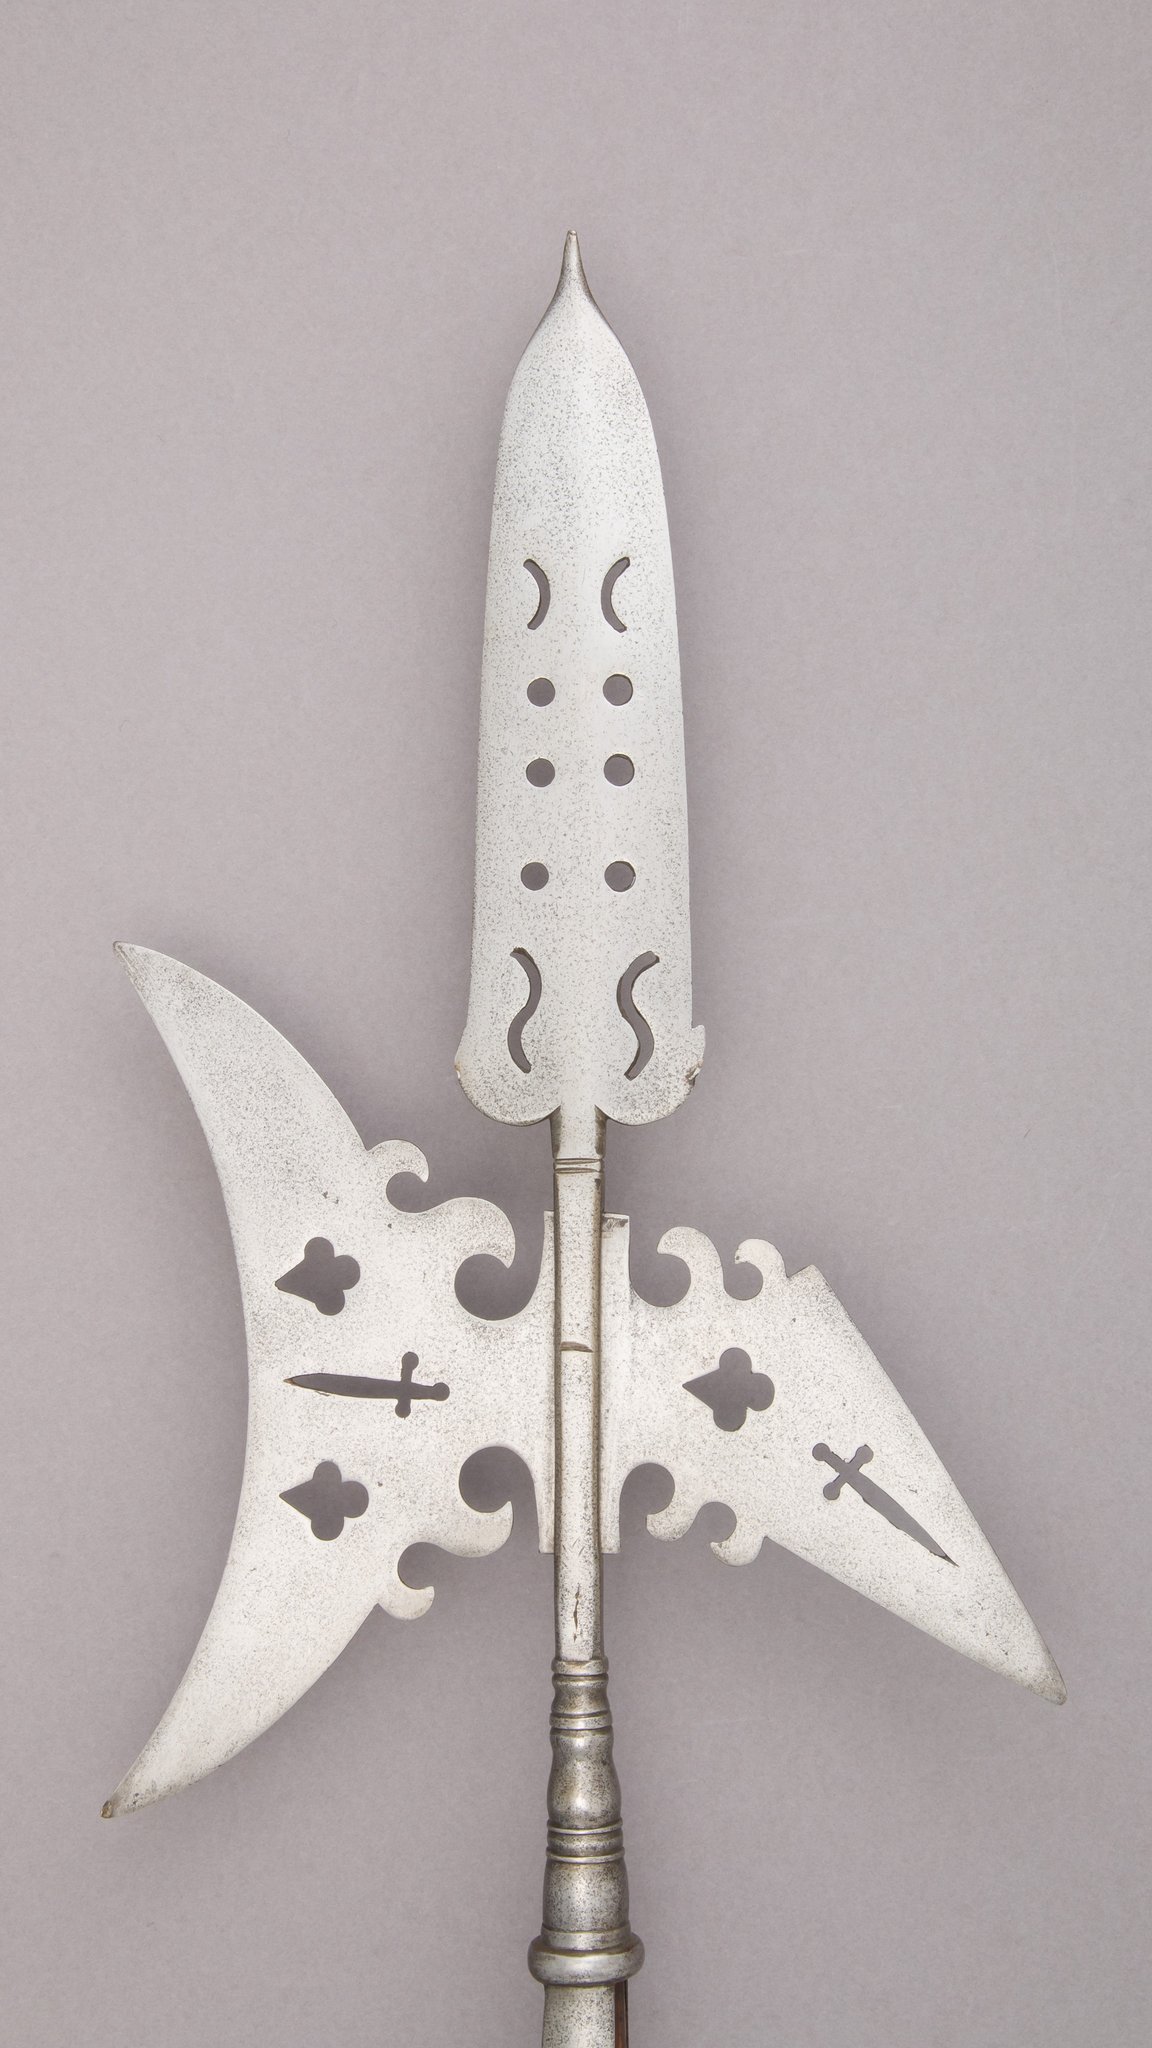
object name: halberd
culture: american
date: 1750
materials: steel, wood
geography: united states